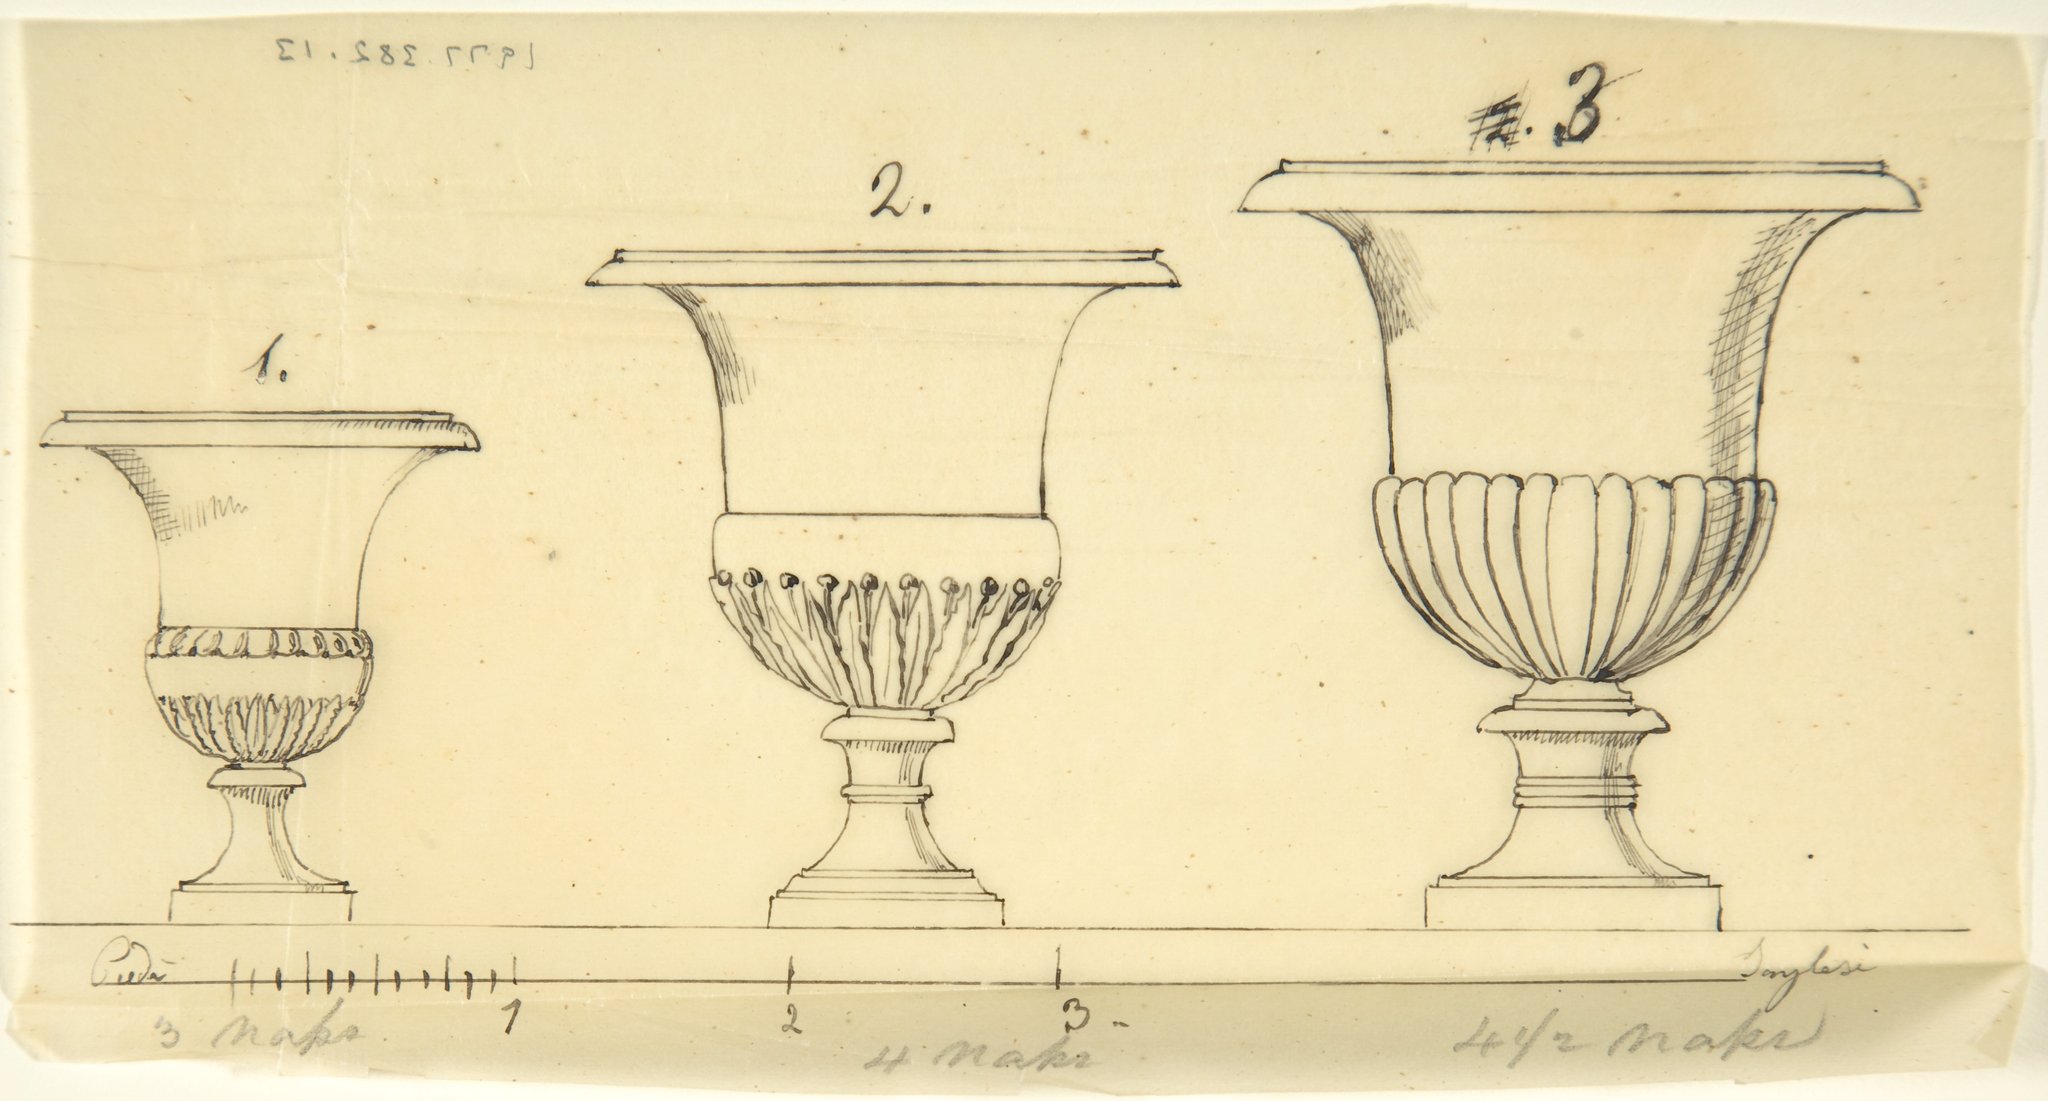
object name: drawing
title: Sketch of Three Vases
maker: john gibson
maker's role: artist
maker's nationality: british, born wales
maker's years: 1790-1866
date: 1850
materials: ink, paper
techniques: pen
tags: vases